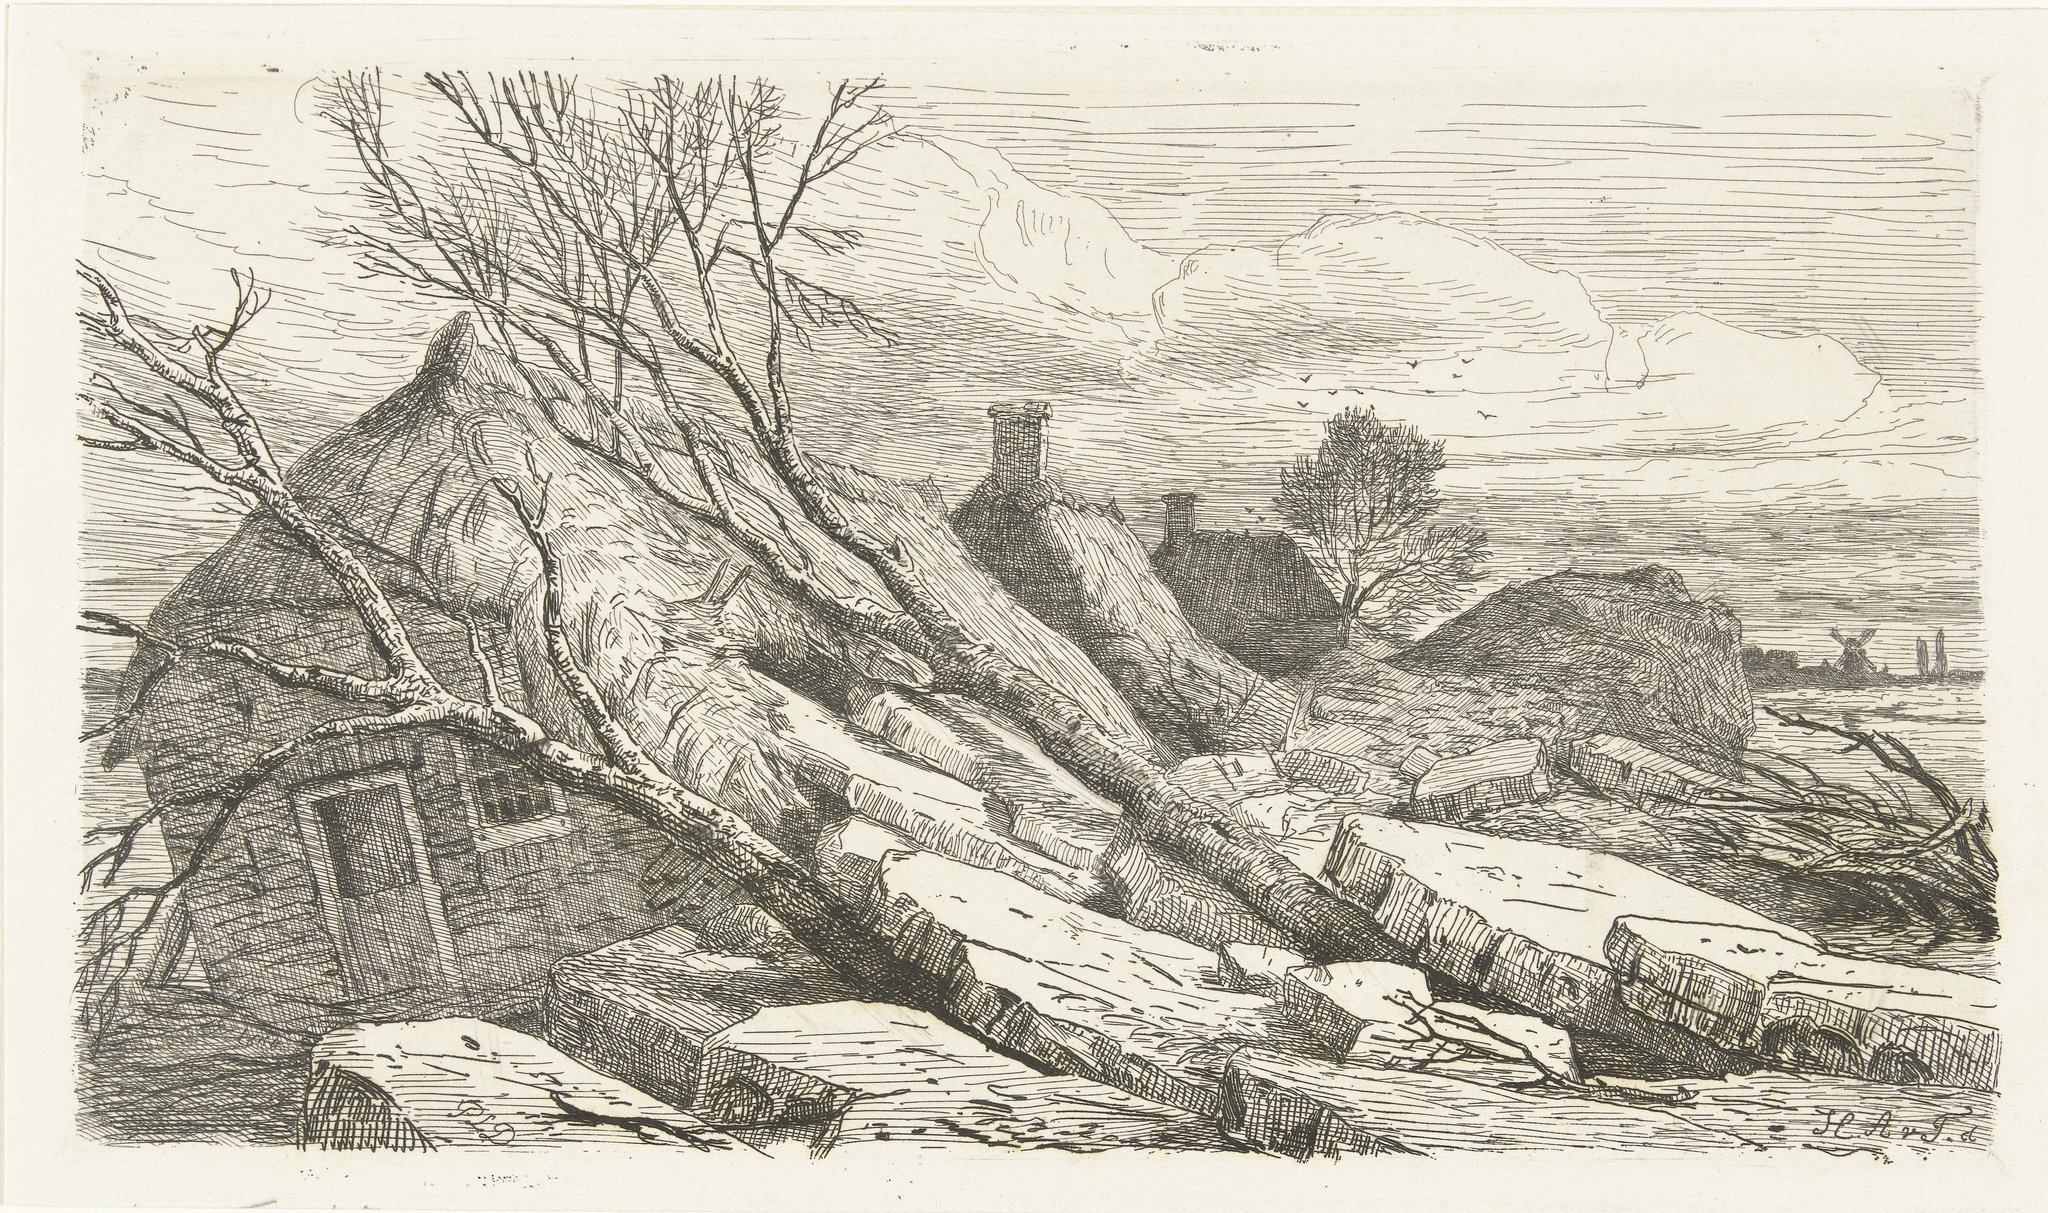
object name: print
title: Gezicht op de dijk tussen Maren en Alem met kruiend ijs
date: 1855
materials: paper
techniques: steel etching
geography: netherlands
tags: drift ice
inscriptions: collector's mark: Lugt 2228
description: Gemaakt voor: De waterramp van 1855. Geschetst in 24 afbeeldingen, naar de natuur geteekend en geëtst door leden der Maatschappij Arti et Amicitiae. Amsterdam: 1855.